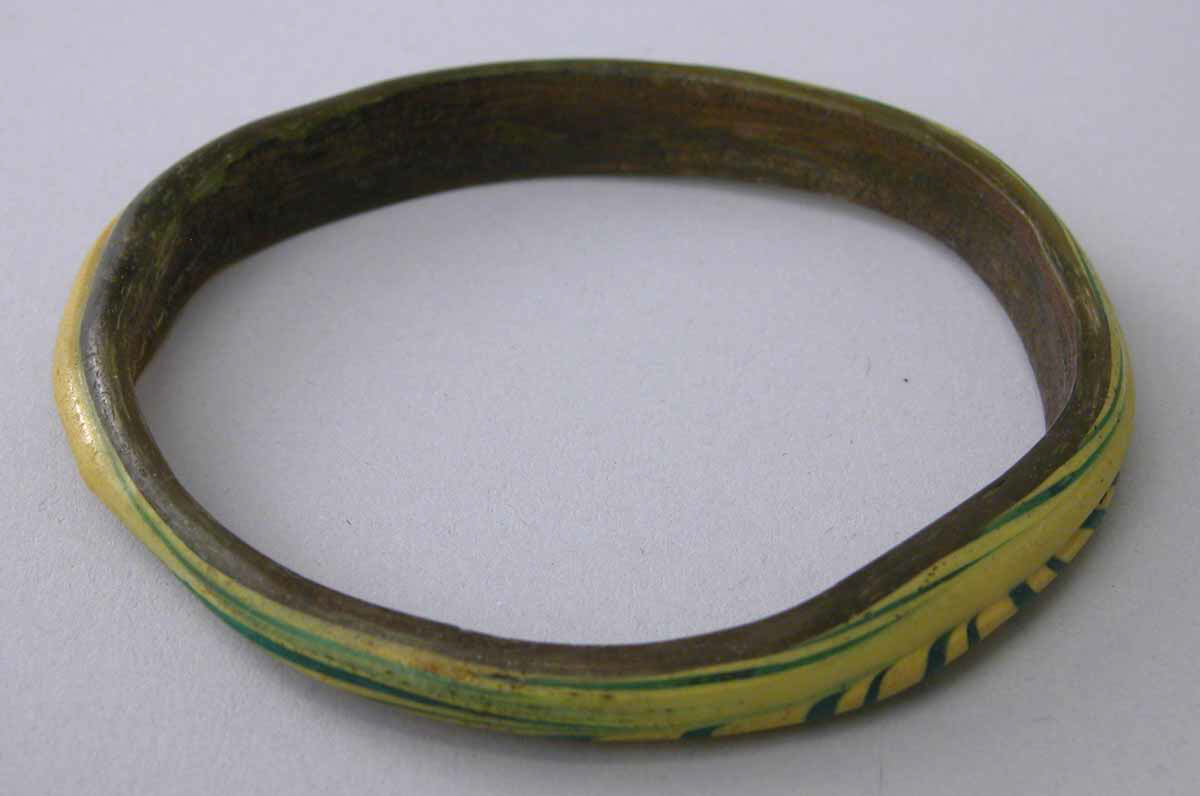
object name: bracelet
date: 1301-1500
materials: glass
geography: egypt or syria